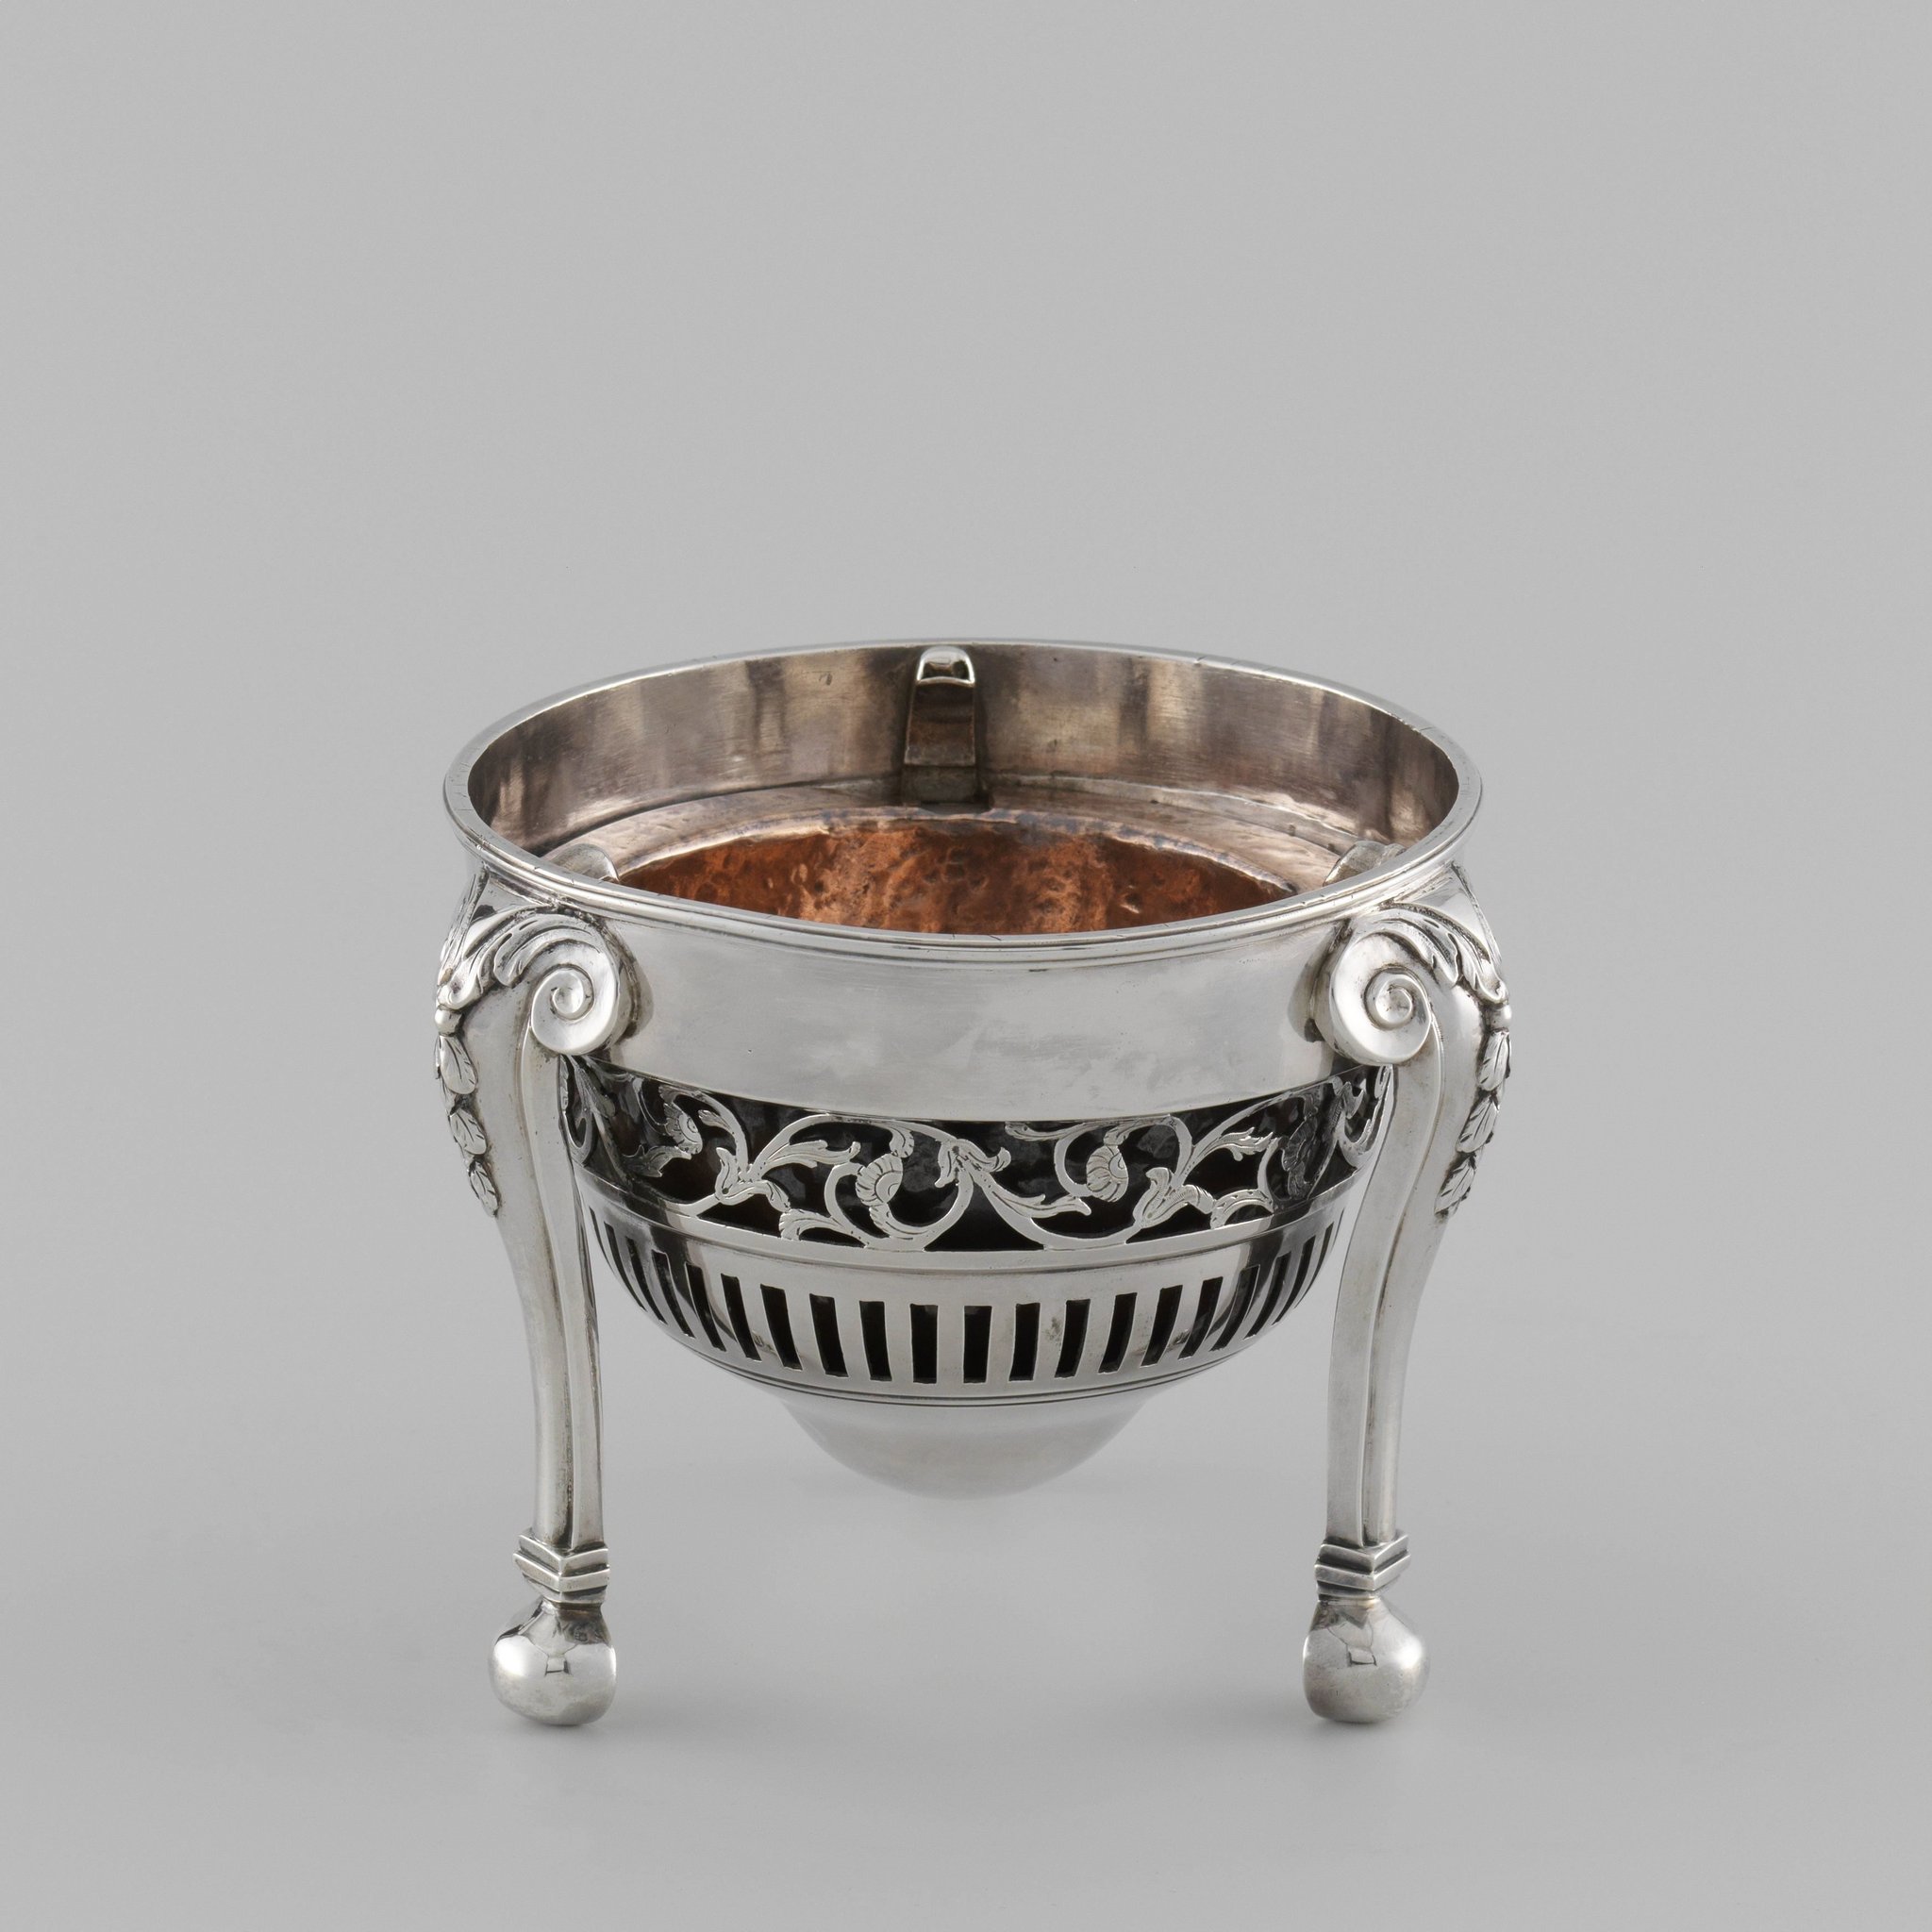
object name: komfoor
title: Tabakskomfoor op drie poten vanaf de bovenrand. Binnenbak van koper.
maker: adrianus wegman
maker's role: silversmith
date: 1794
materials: copper, silver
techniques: casting, metalworking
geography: the hague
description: Rond tabakskomfoor op drie poten, die onder de bovenrand zijn bevestigd. Aan de binnenzijde van het lichaam steunt op een uitstekende rand de losse koperen binnenbak.